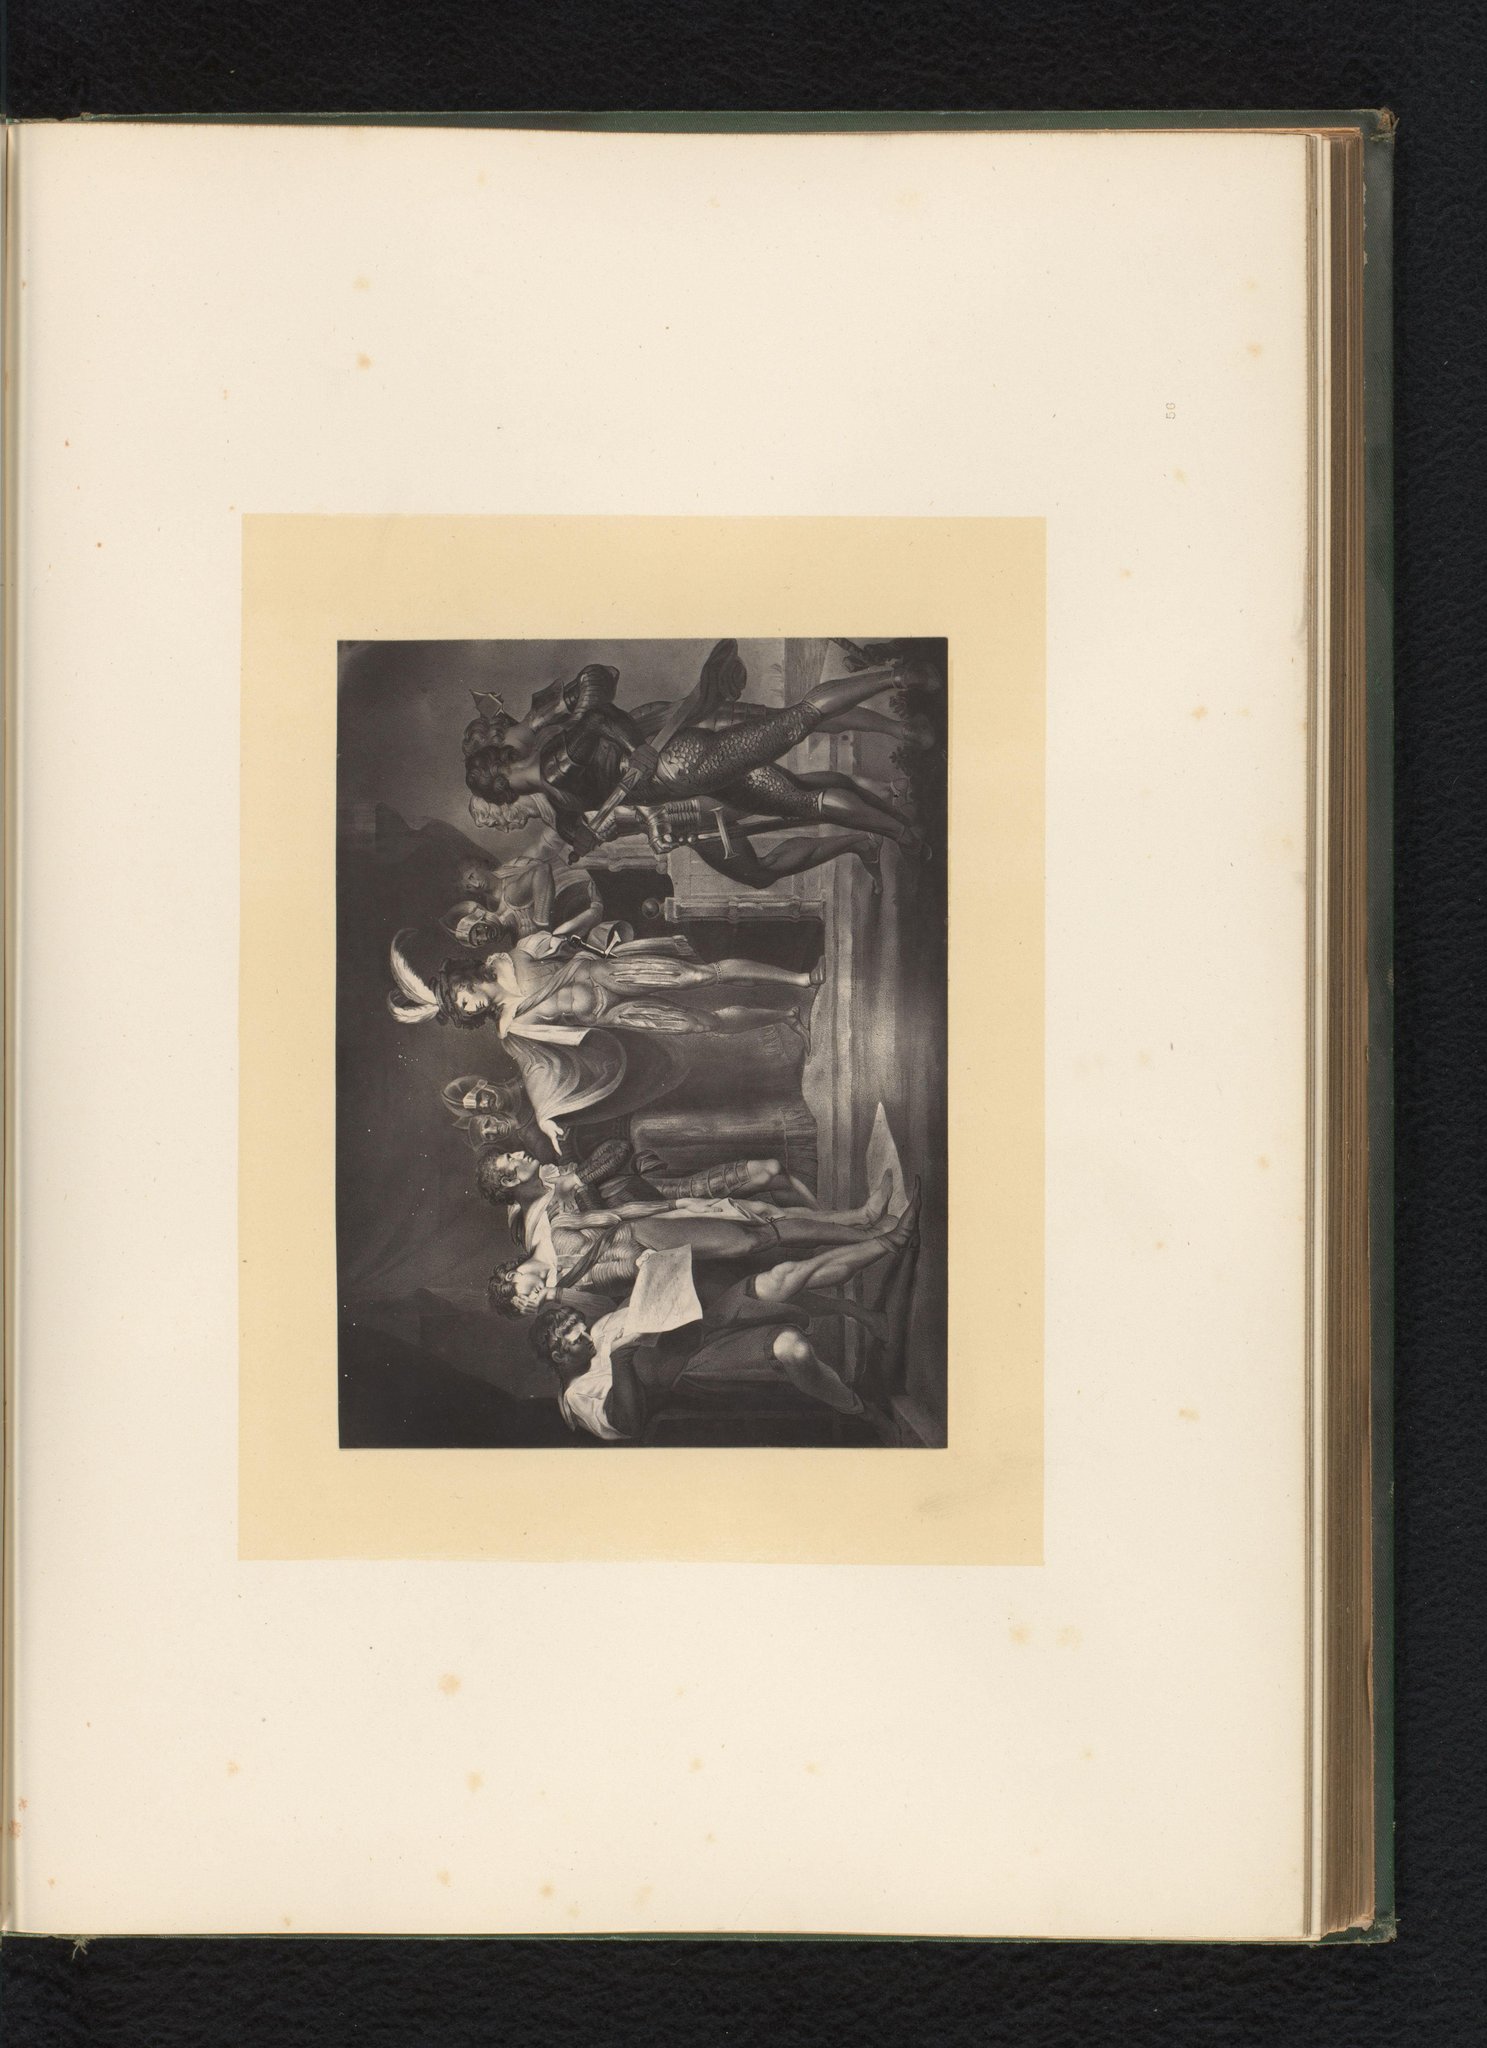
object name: page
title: Reproductie van een gravure naar een schilderij van een scène uit King Henry the Fifth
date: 1874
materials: paper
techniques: woodburytype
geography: london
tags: theatre, theatrical performance